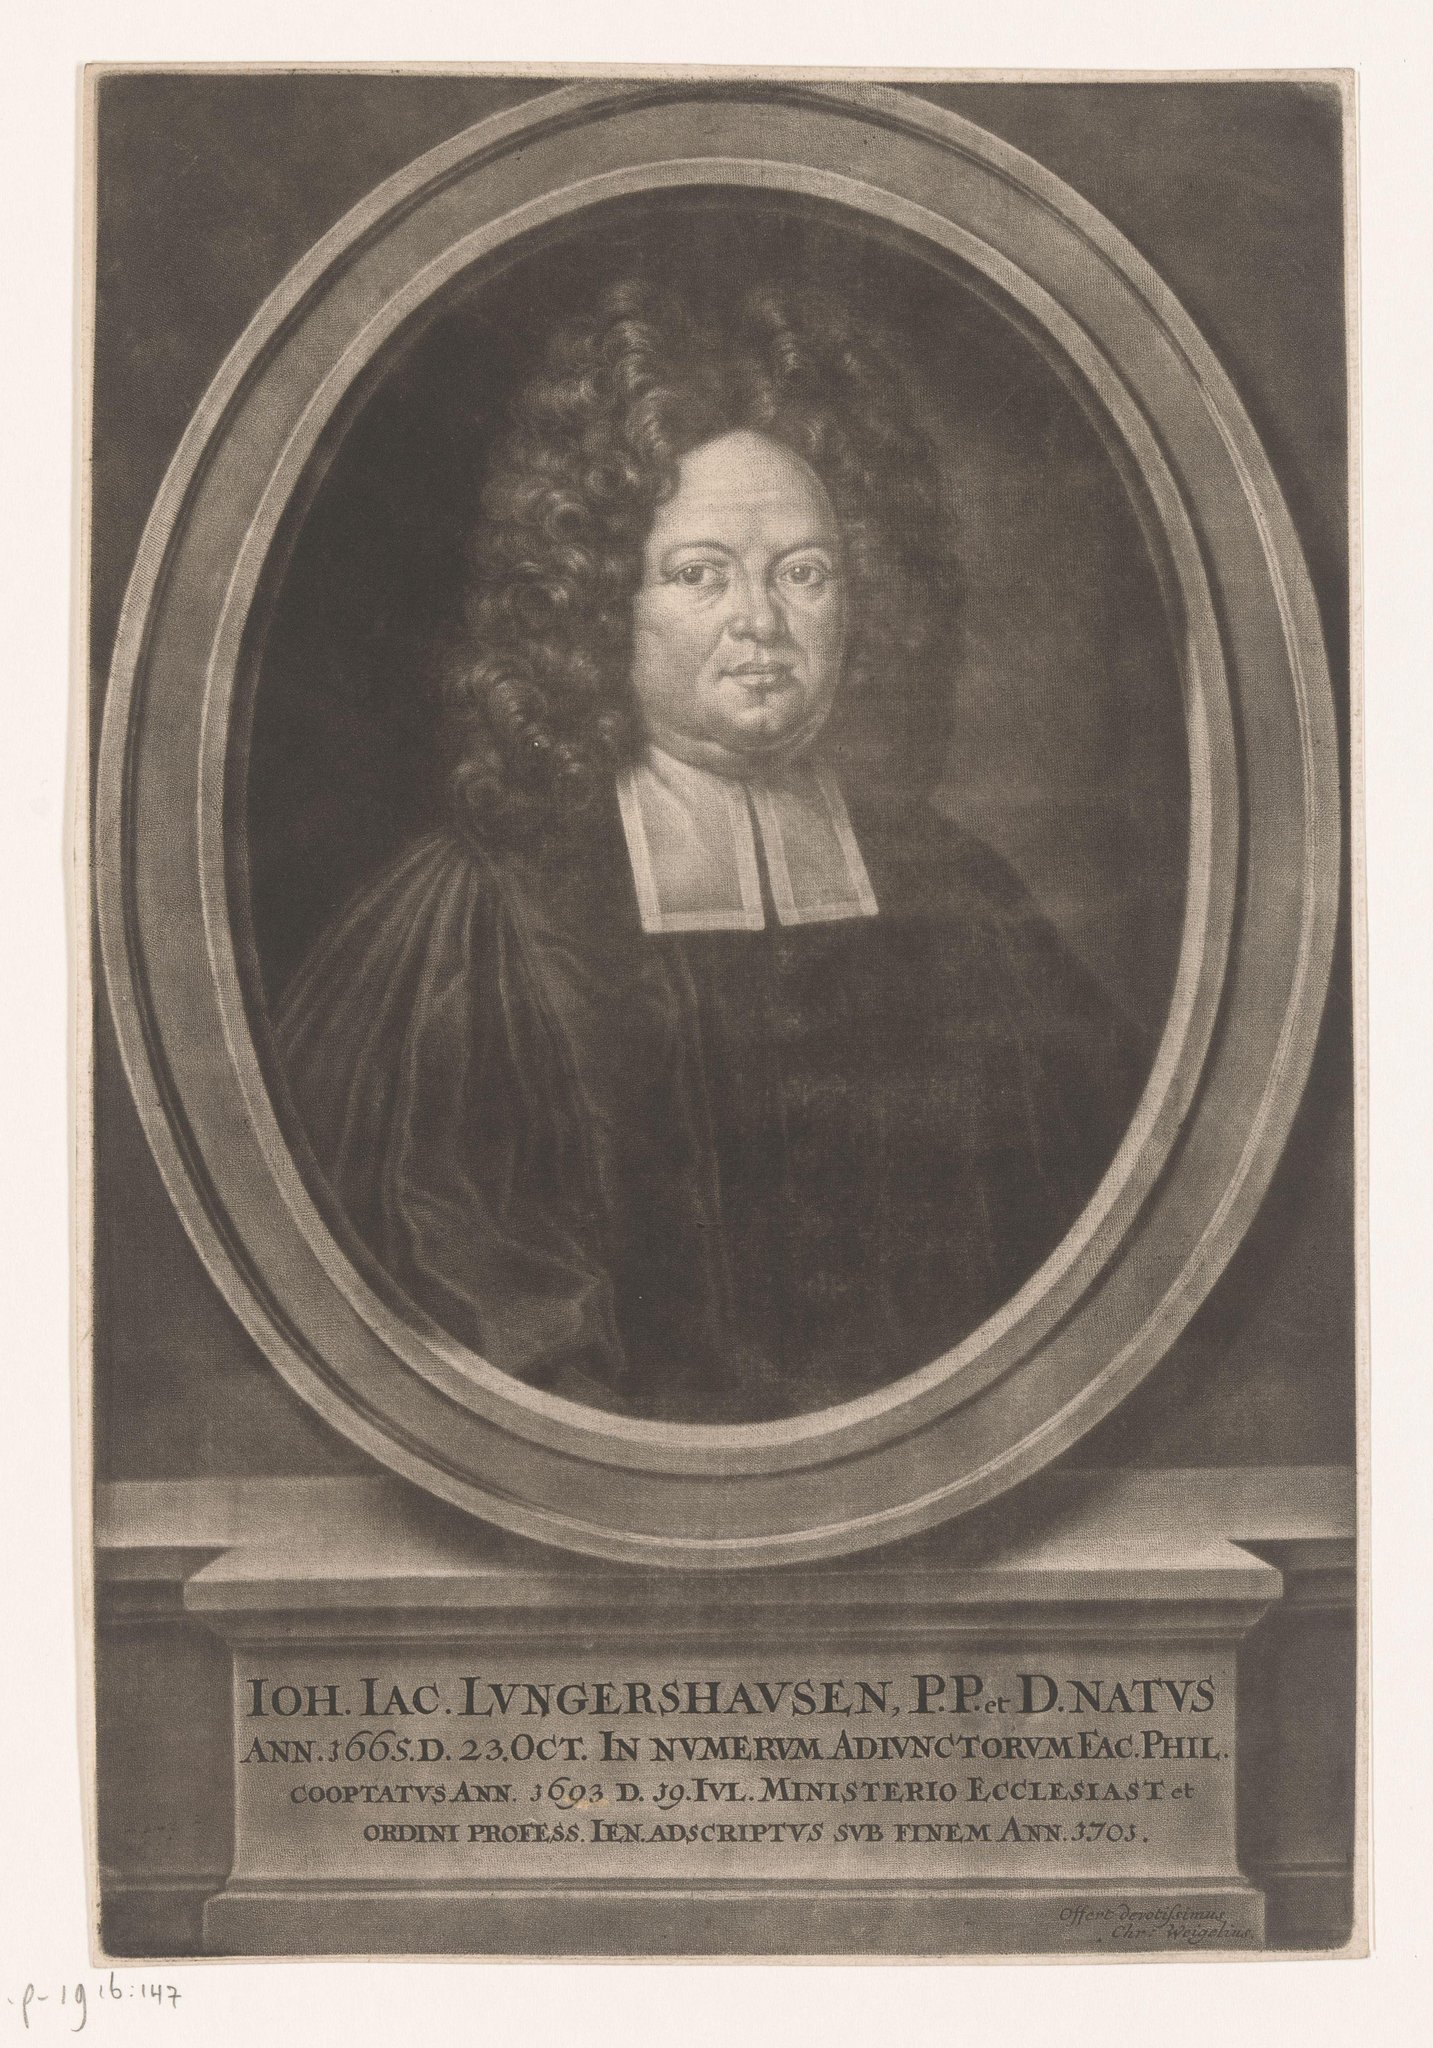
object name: print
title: Portret van Johann Jacob Lungerhausen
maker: christoph weigel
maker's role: goldsmith, print maker, publisher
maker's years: 1654-1725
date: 1703-1725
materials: paper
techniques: mezzotint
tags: mühlhausen, historical persons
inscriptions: collector's mark: Lugt 2228